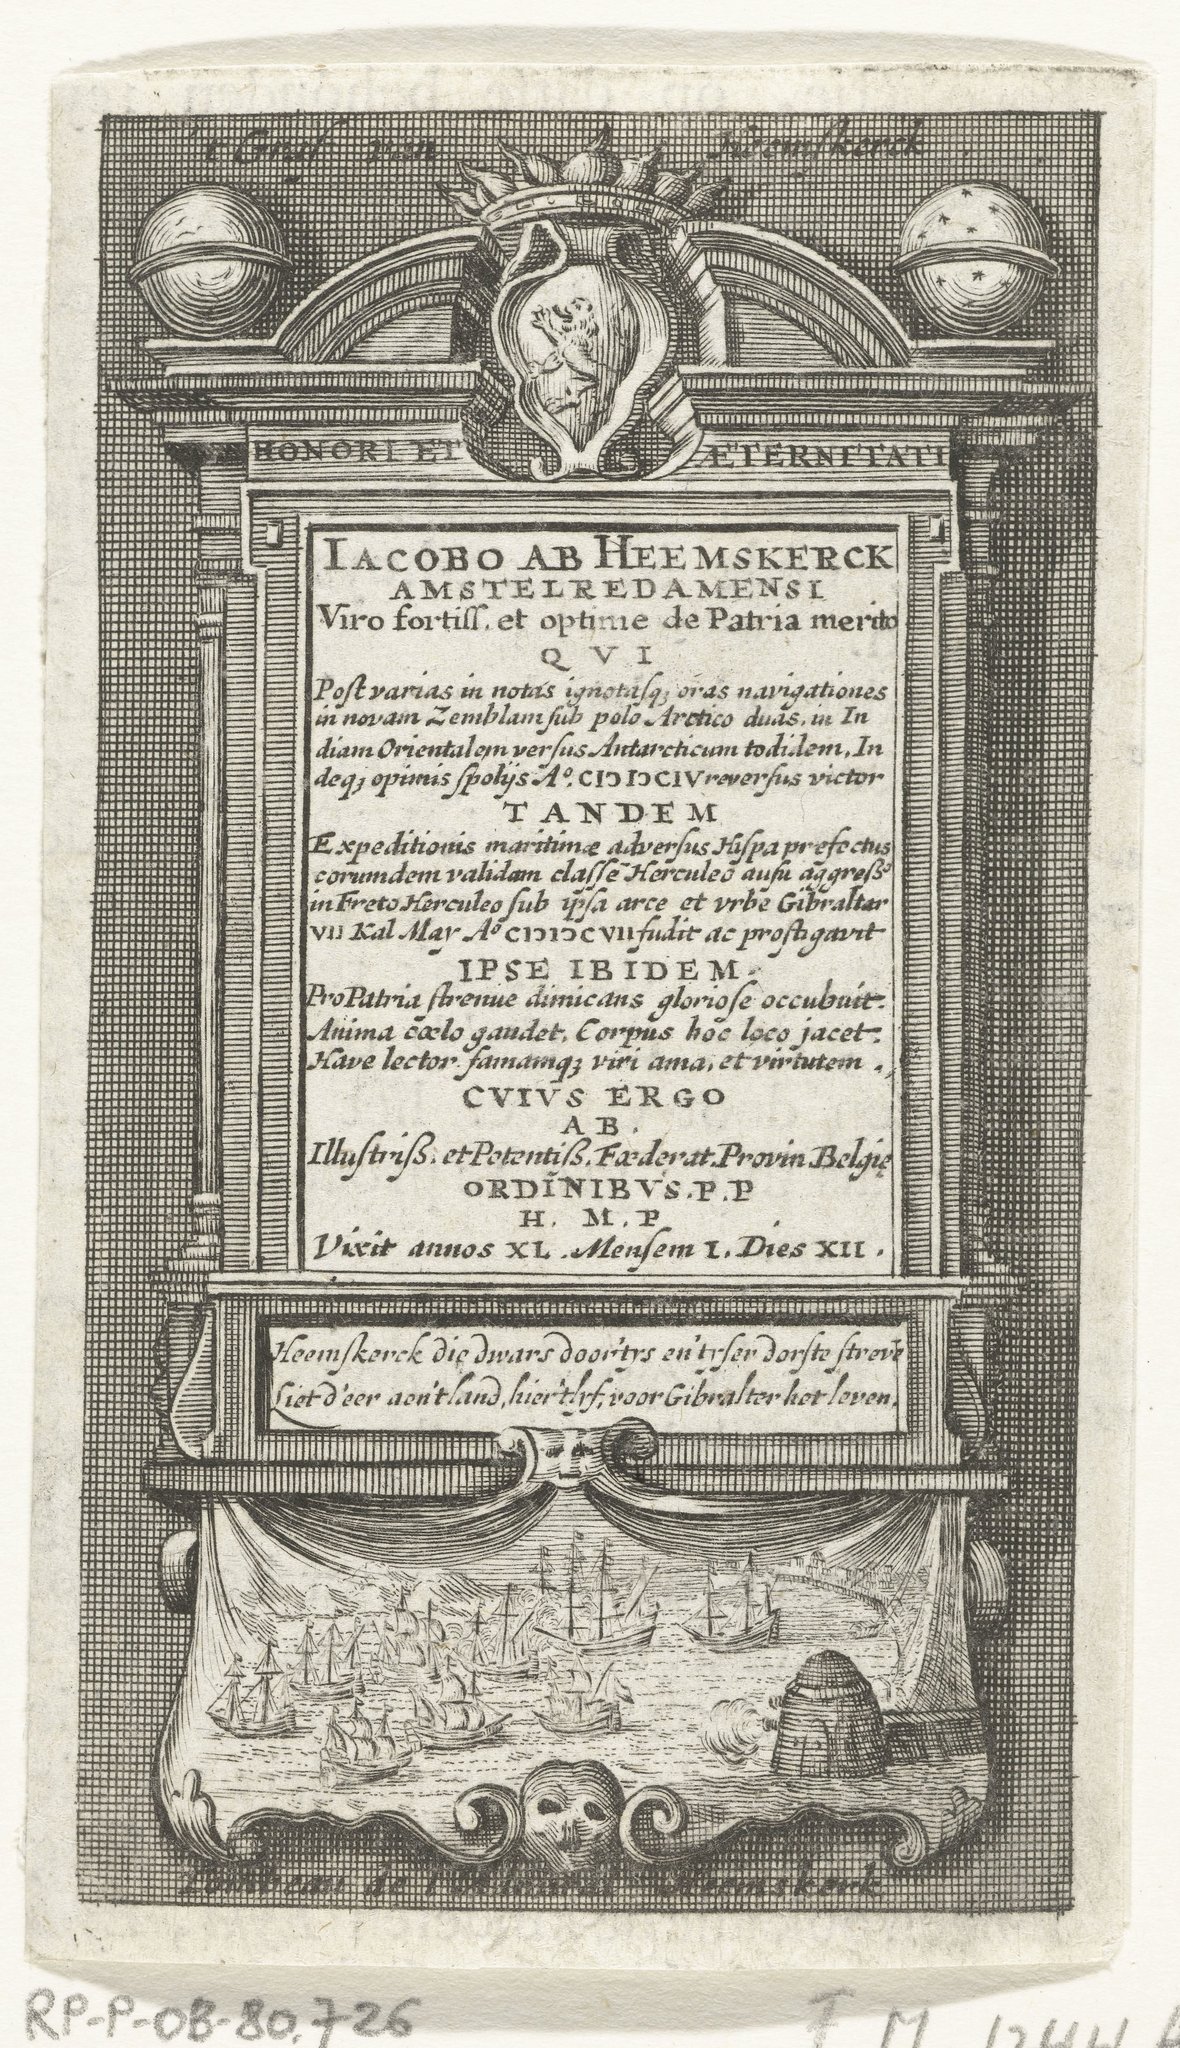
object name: print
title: 't Graf van Heemskerck / Tombeau de l'Admiral Heemskerk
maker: Anonymous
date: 1607-1699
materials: paper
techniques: etching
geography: northern netherlands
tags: amsterdam, jacob van heemskerck, battle (+ naval force), grave-building, monumental tomb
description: Grafmonument of memorietafel voor admiraal Jacob van Heemskerck in de Oude Kerk te Amsterdam. Gesneuveld tijdens de zeeslag tussen de Staatse en Spaanse vloten in de baai van Gibraltar op 25 april 1607 en begraven op 8 juni 1607. Memorietafel met tekst in het Latijn en tweeregelig vers in het Nederlands. Onderaan een voorstelling van de zeeslag bij Gibraltar.